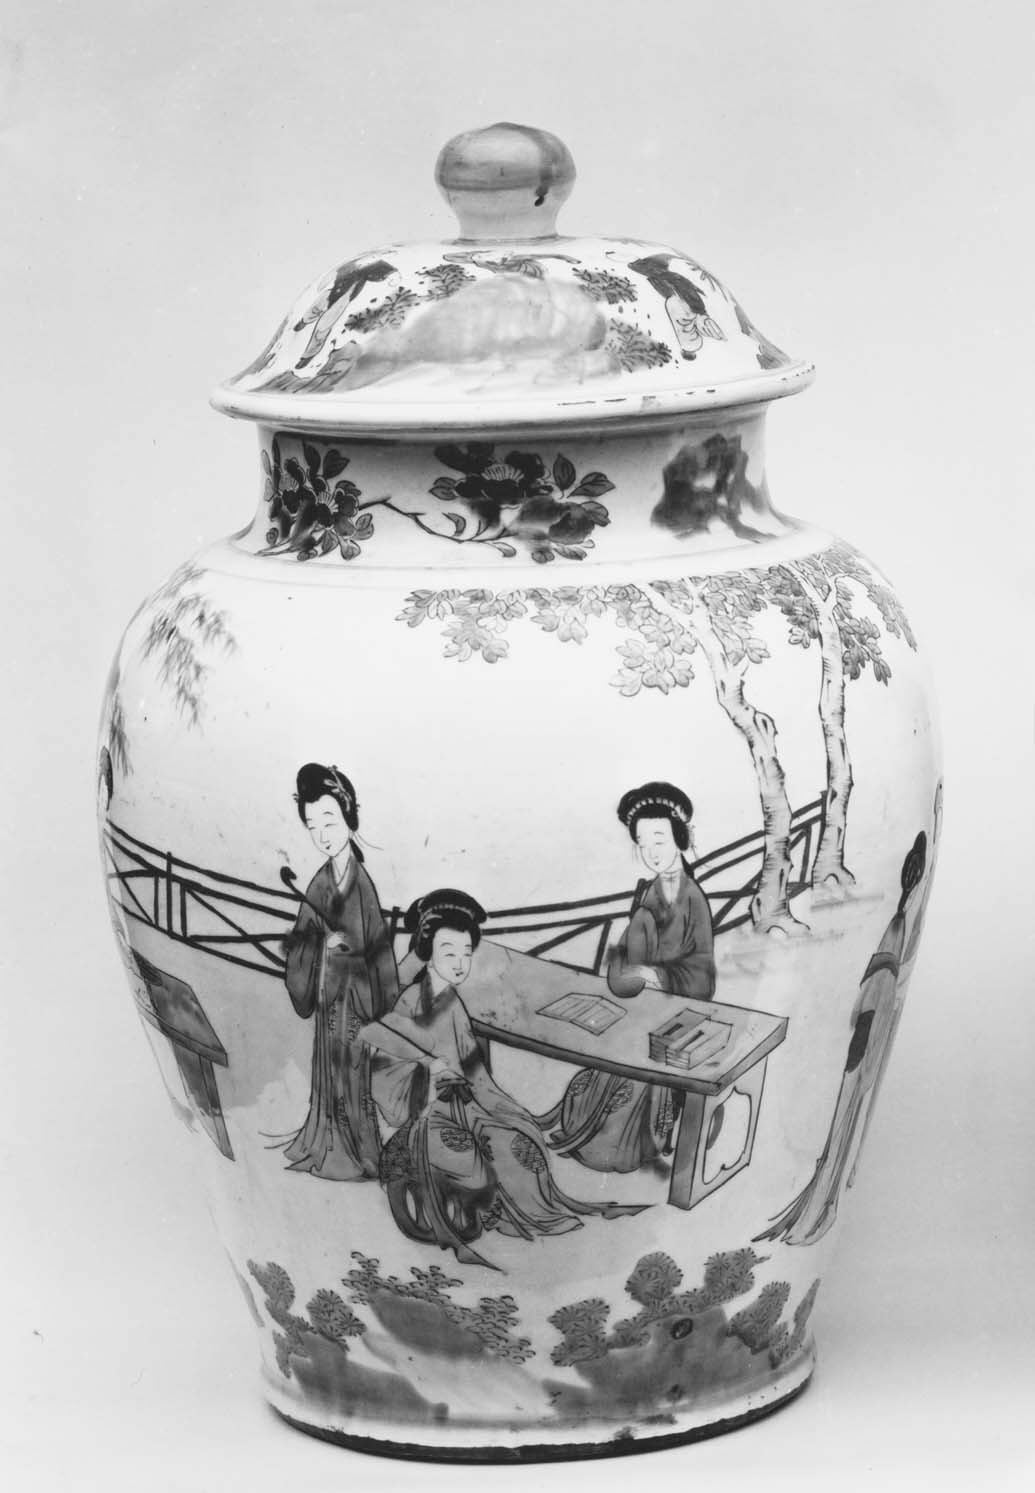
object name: jar with cover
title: Jar with Cover (one of a pair)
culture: chinese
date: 1644-1722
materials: porcelain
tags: women,trees,tables